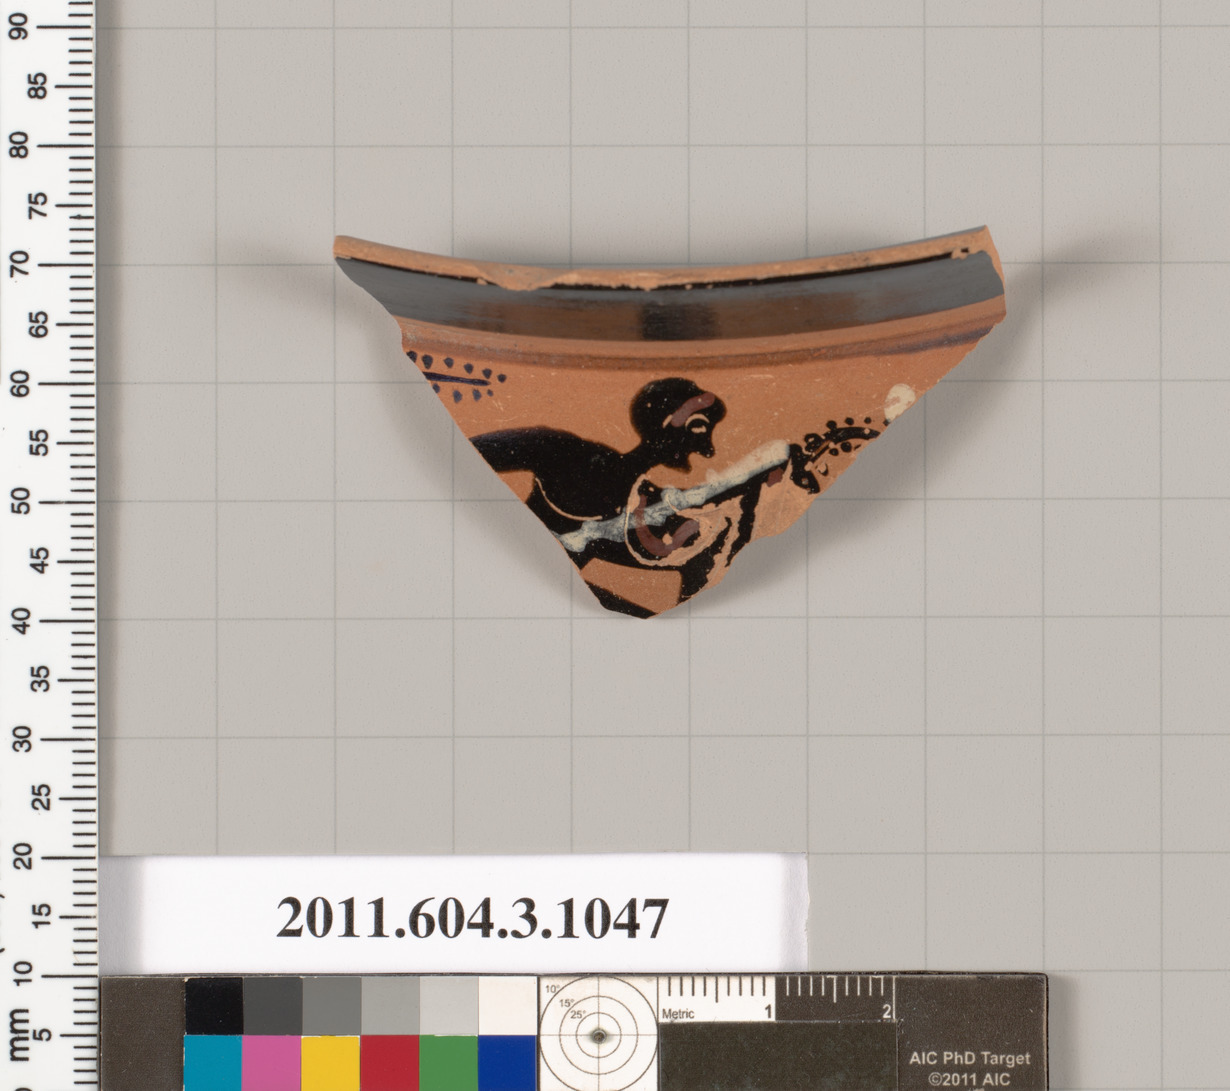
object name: mastoid fragment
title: Terracotta fragment of a mastoid (drinking cup with narrow base)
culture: greek, attic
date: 534-468 BCE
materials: terracotta